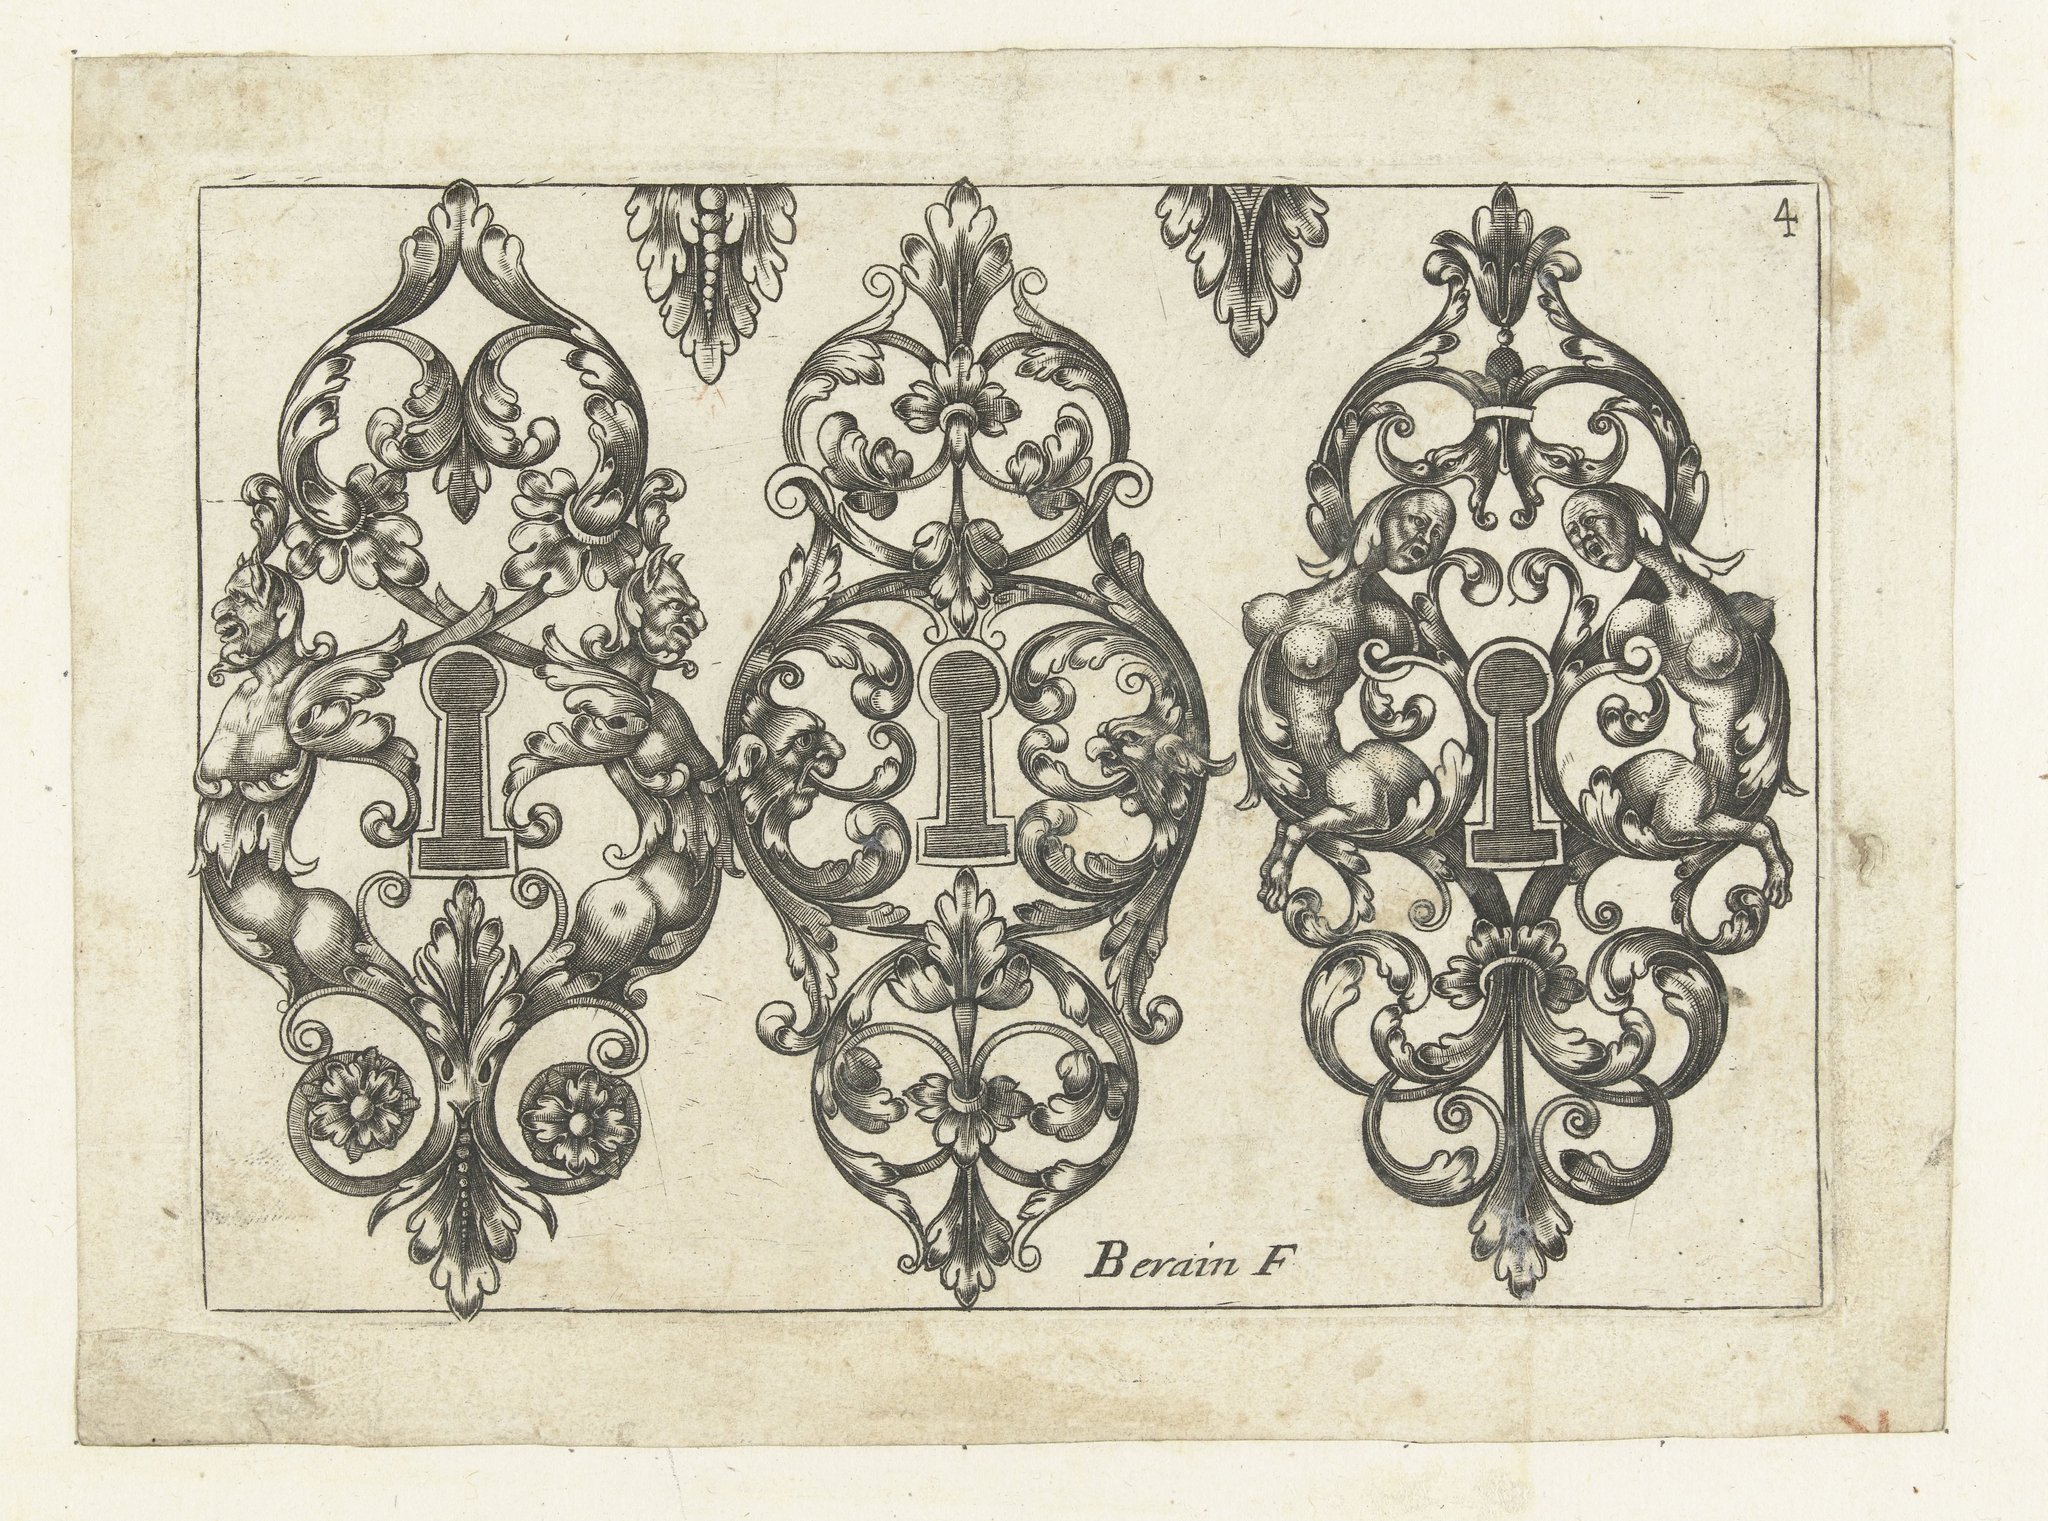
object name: ornament print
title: Diverses Pièces de Serruriers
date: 1662-1711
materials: paper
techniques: engraving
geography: paris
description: Blad 4 uit serie van titelblad, blad met opdracht en 14 bladen met beslag en smeedwerk, sleutelgatplaten, sleutels, deurkloppers en deurknoppen. Tweede editie.